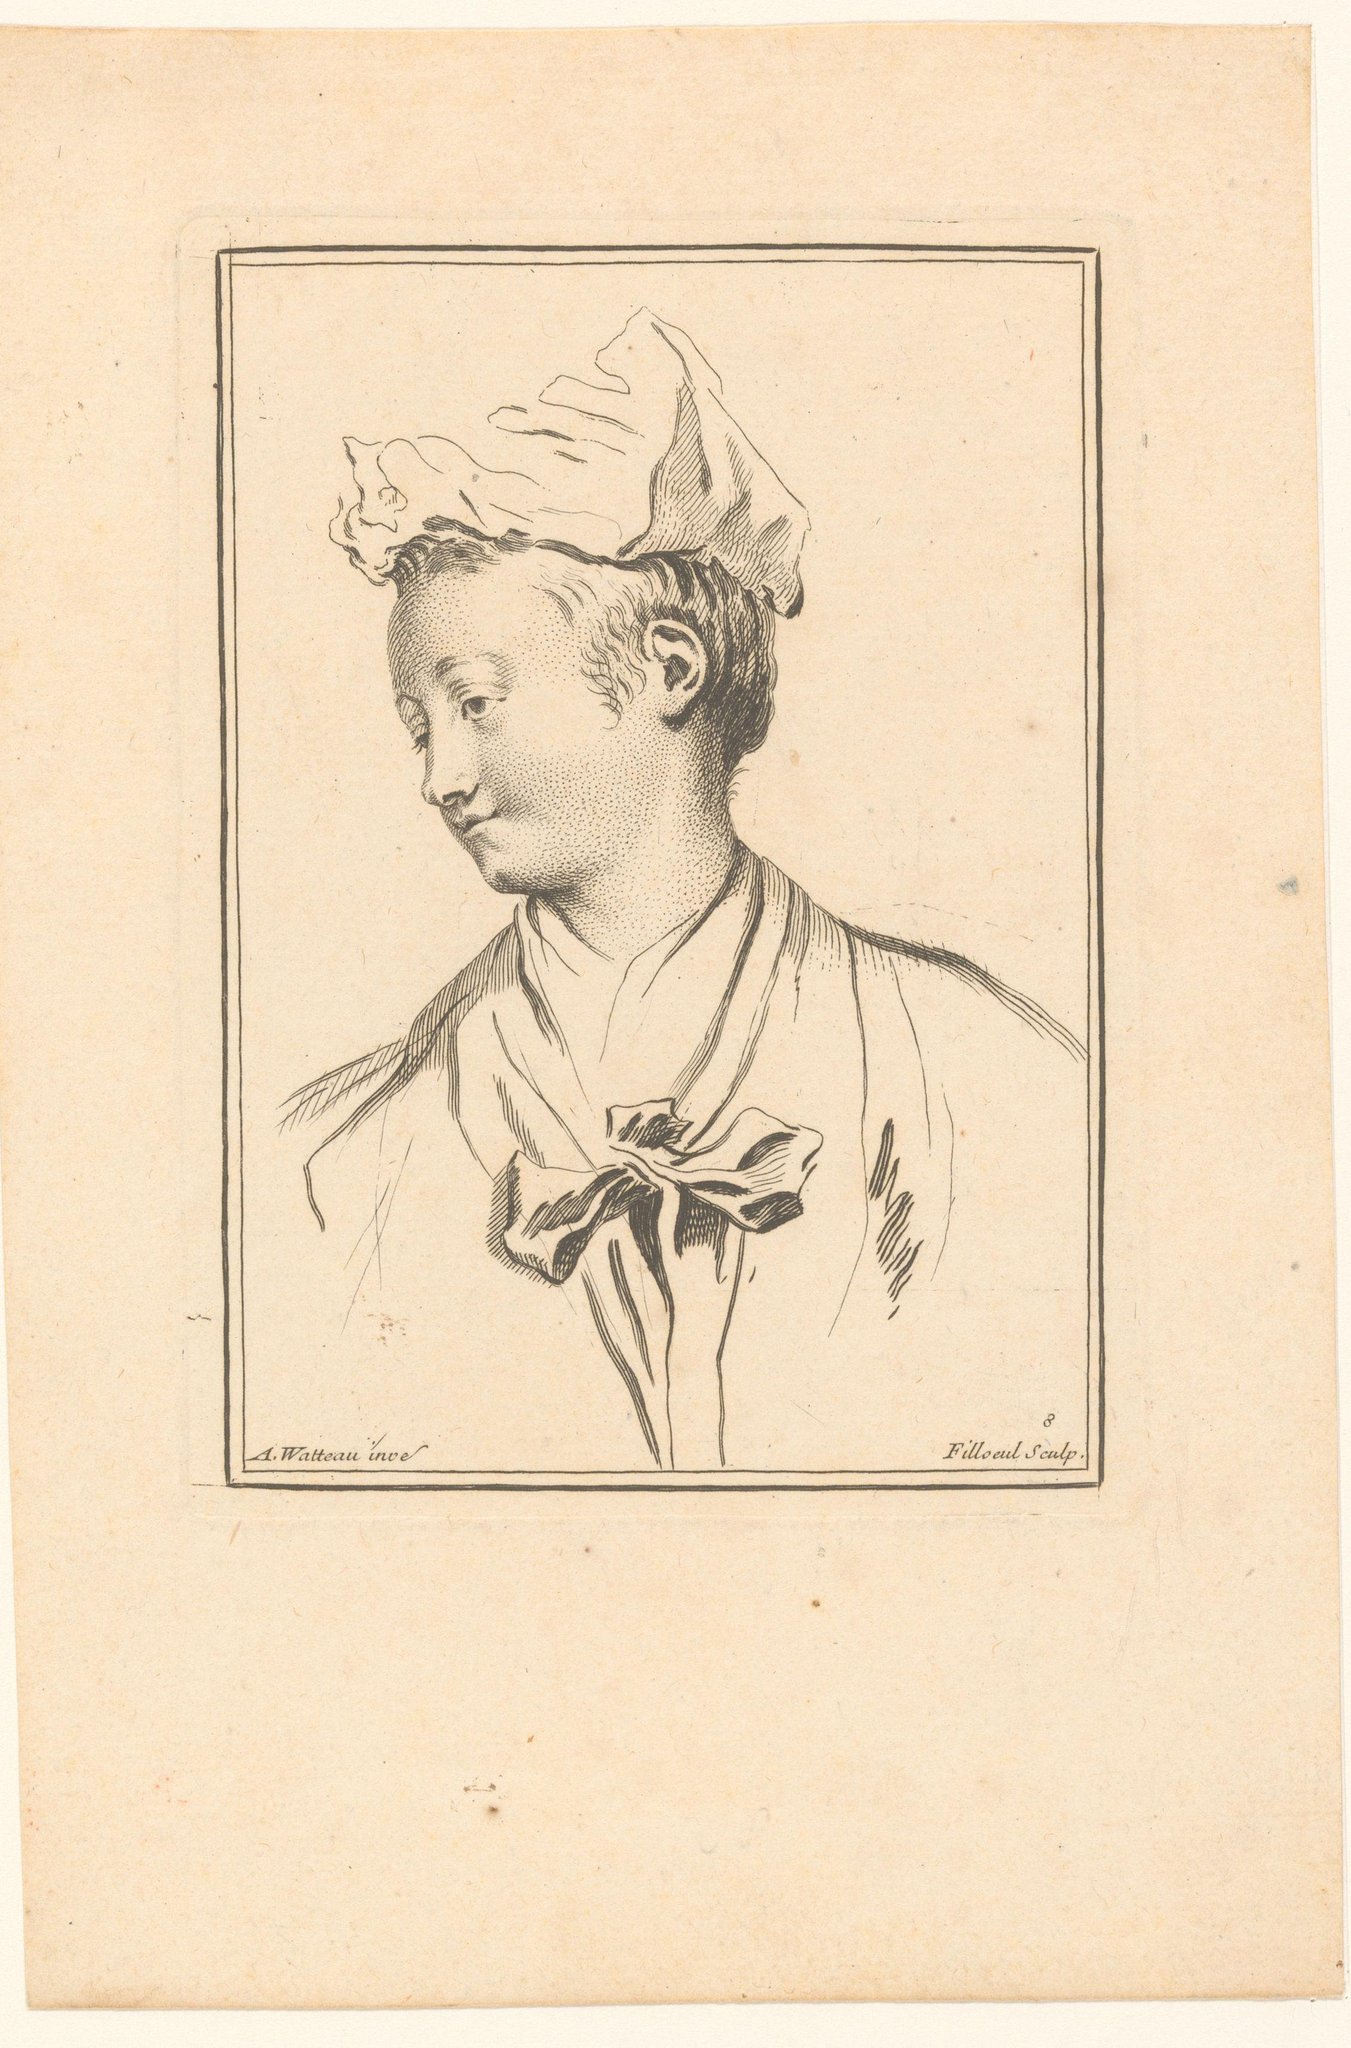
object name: print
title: Livre de différents caractères de Têtes. Inventez par M. Watteaux (...)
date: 1734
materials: paper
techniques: engraving, etching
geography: france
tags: adolescent, young woman, maiden, head-gear: cap (+ women's clothes), anonymous historical person portrayed - bb - woman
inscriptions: collector's mark: Lugt 533b